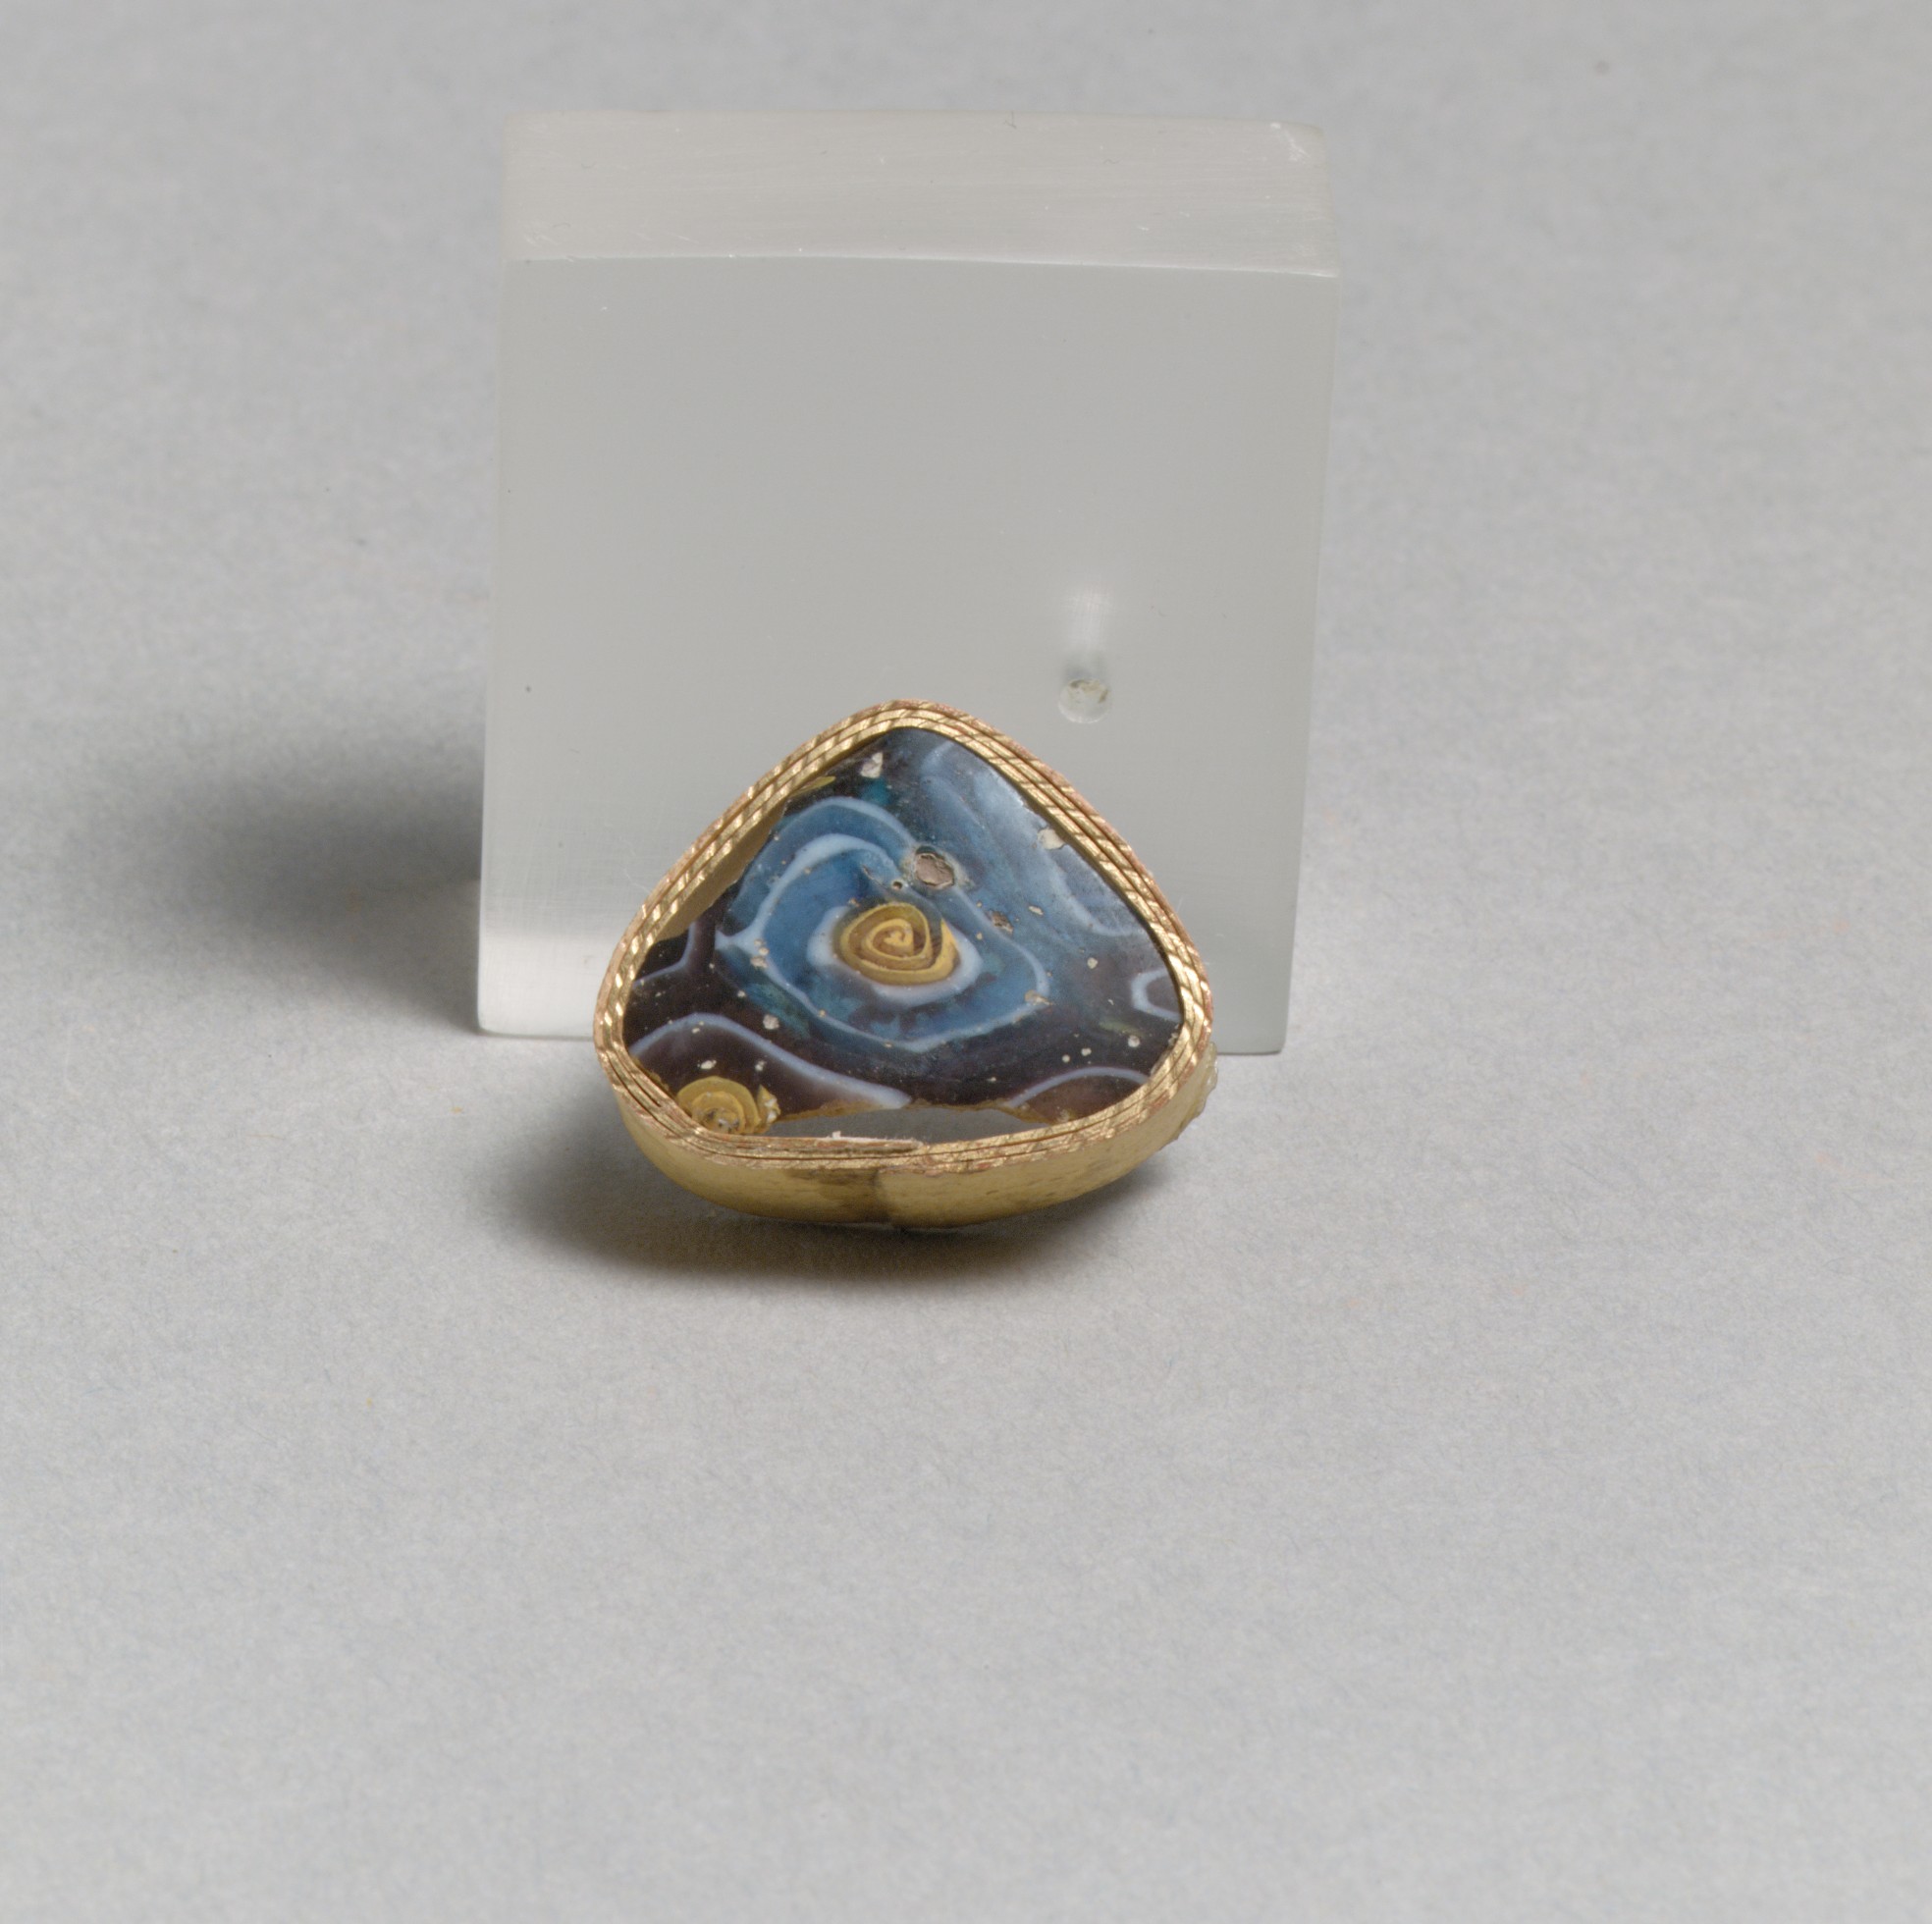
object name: fragment, mosaic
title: Glass mosaic fragment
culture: roman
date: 34 BCE-33 CE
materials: glass